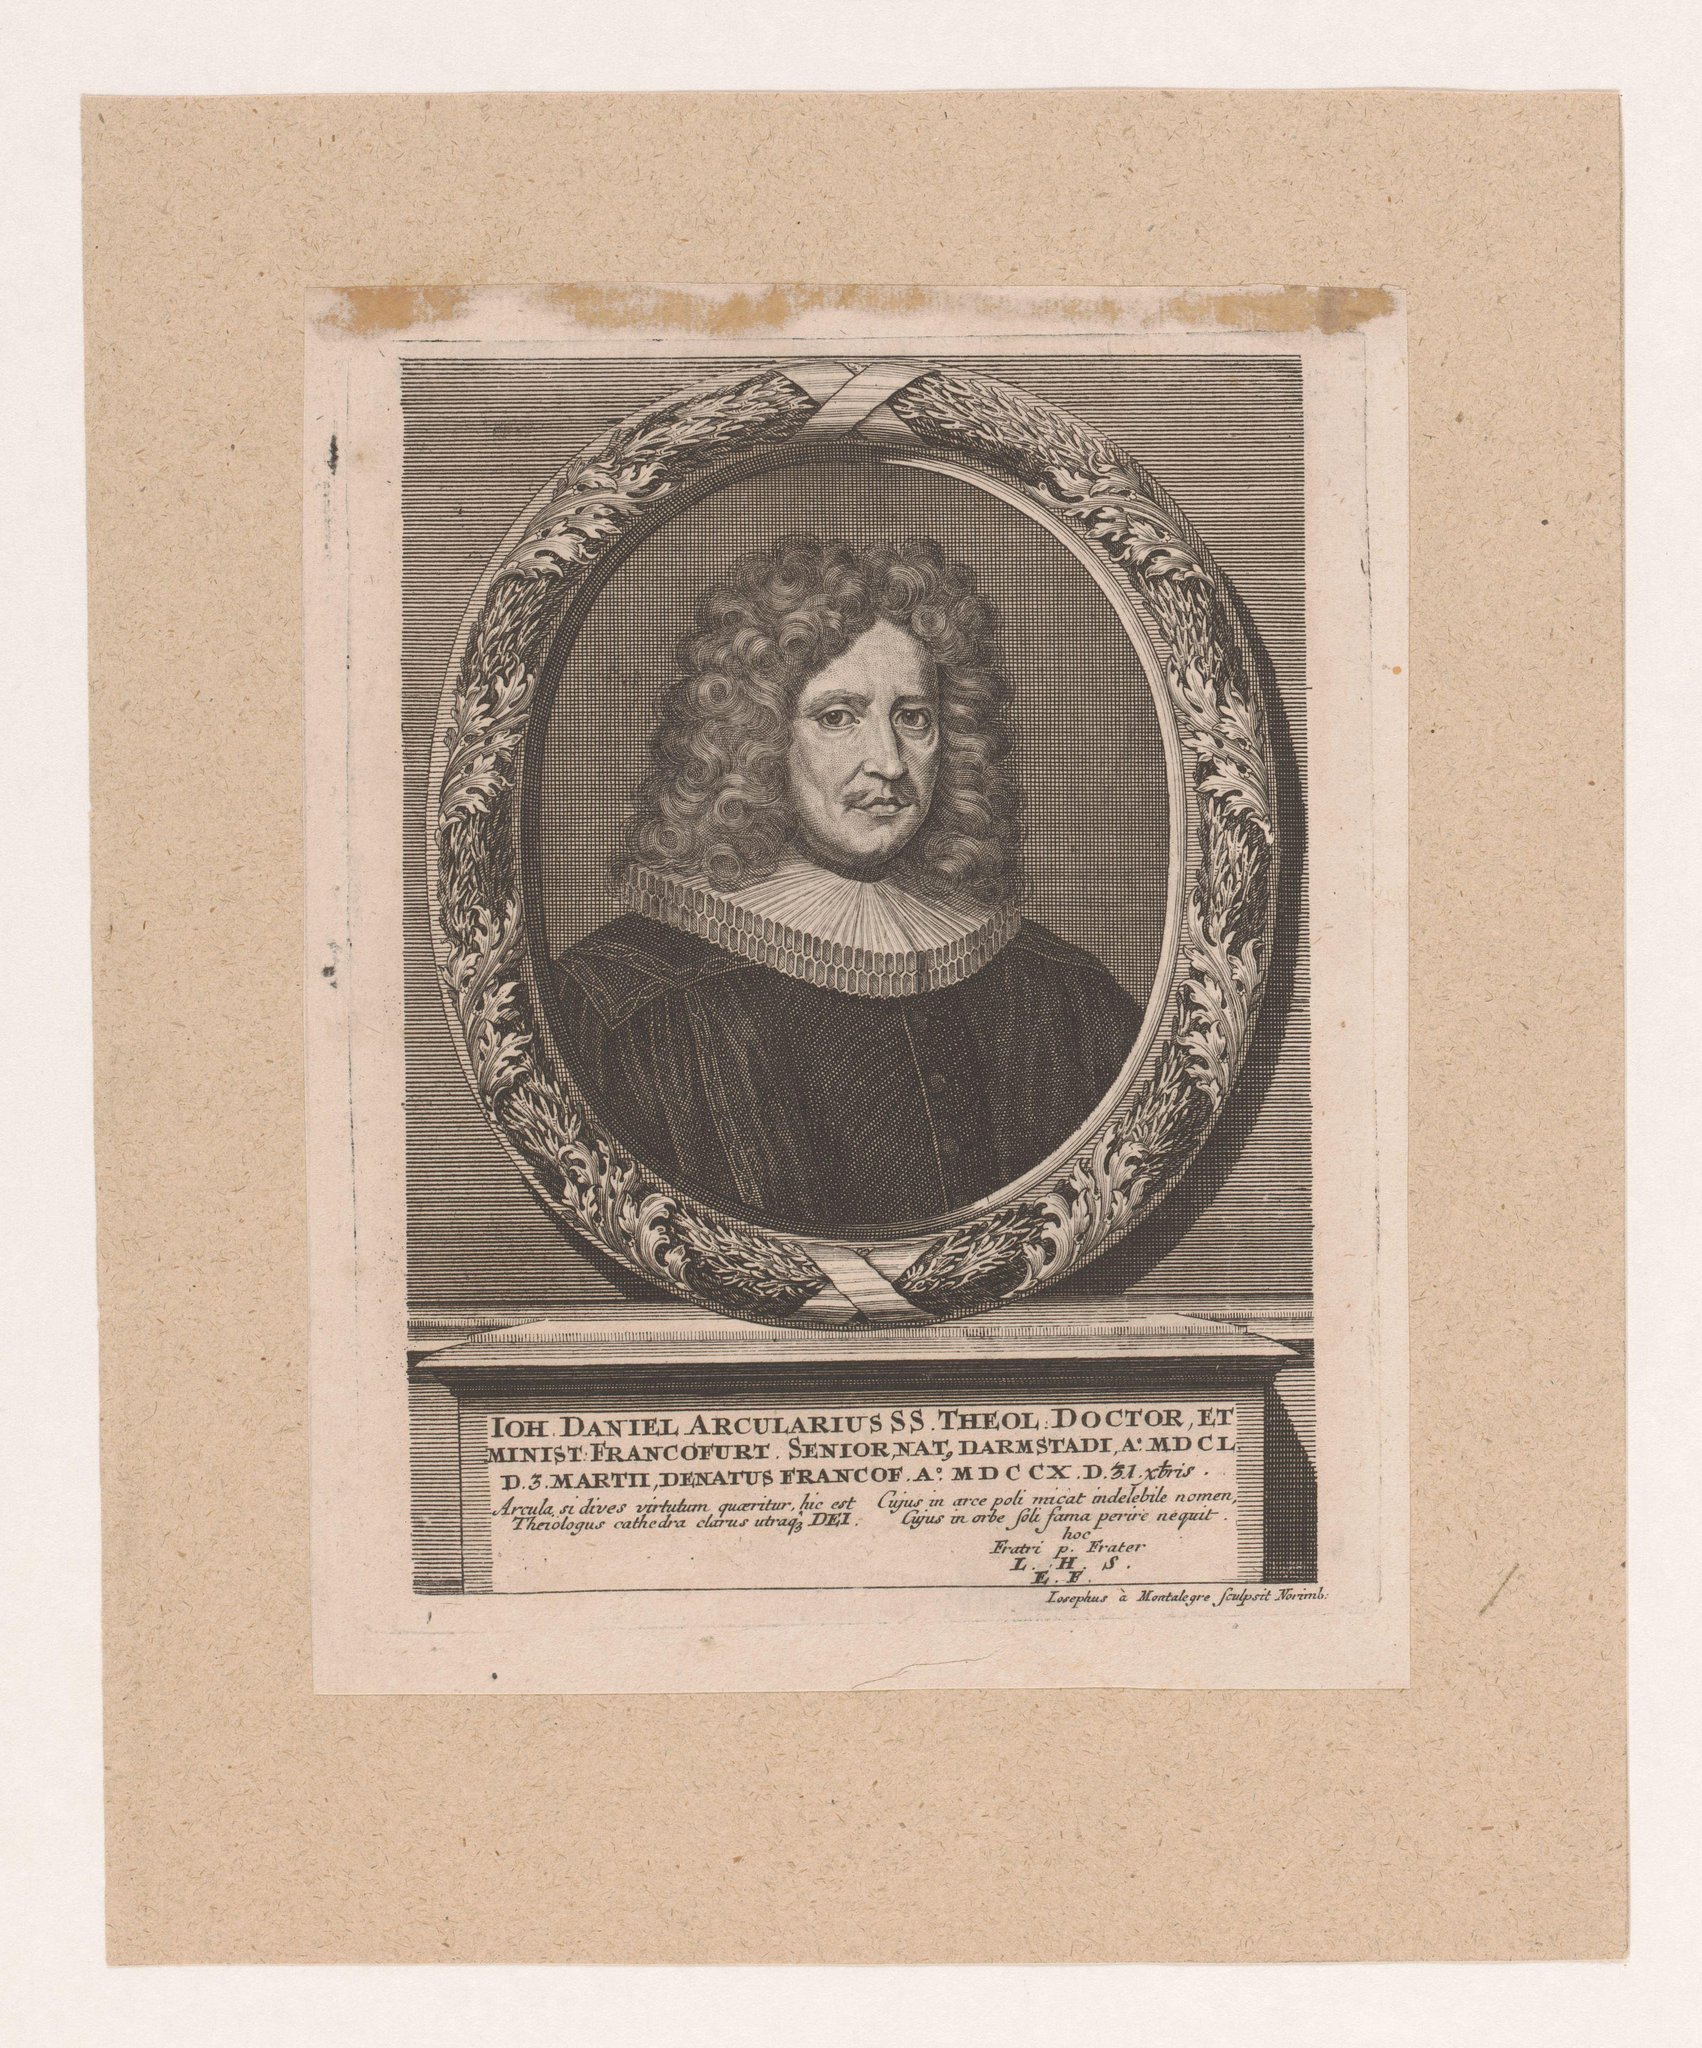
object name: print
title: Portret van Johann Daniel Arcularius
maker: joseph de montalegre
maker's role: print maker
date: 1690-1799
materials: paper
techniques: engraving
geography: nuremberg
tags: historical persons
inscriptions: collector's mark: Lugt 2228